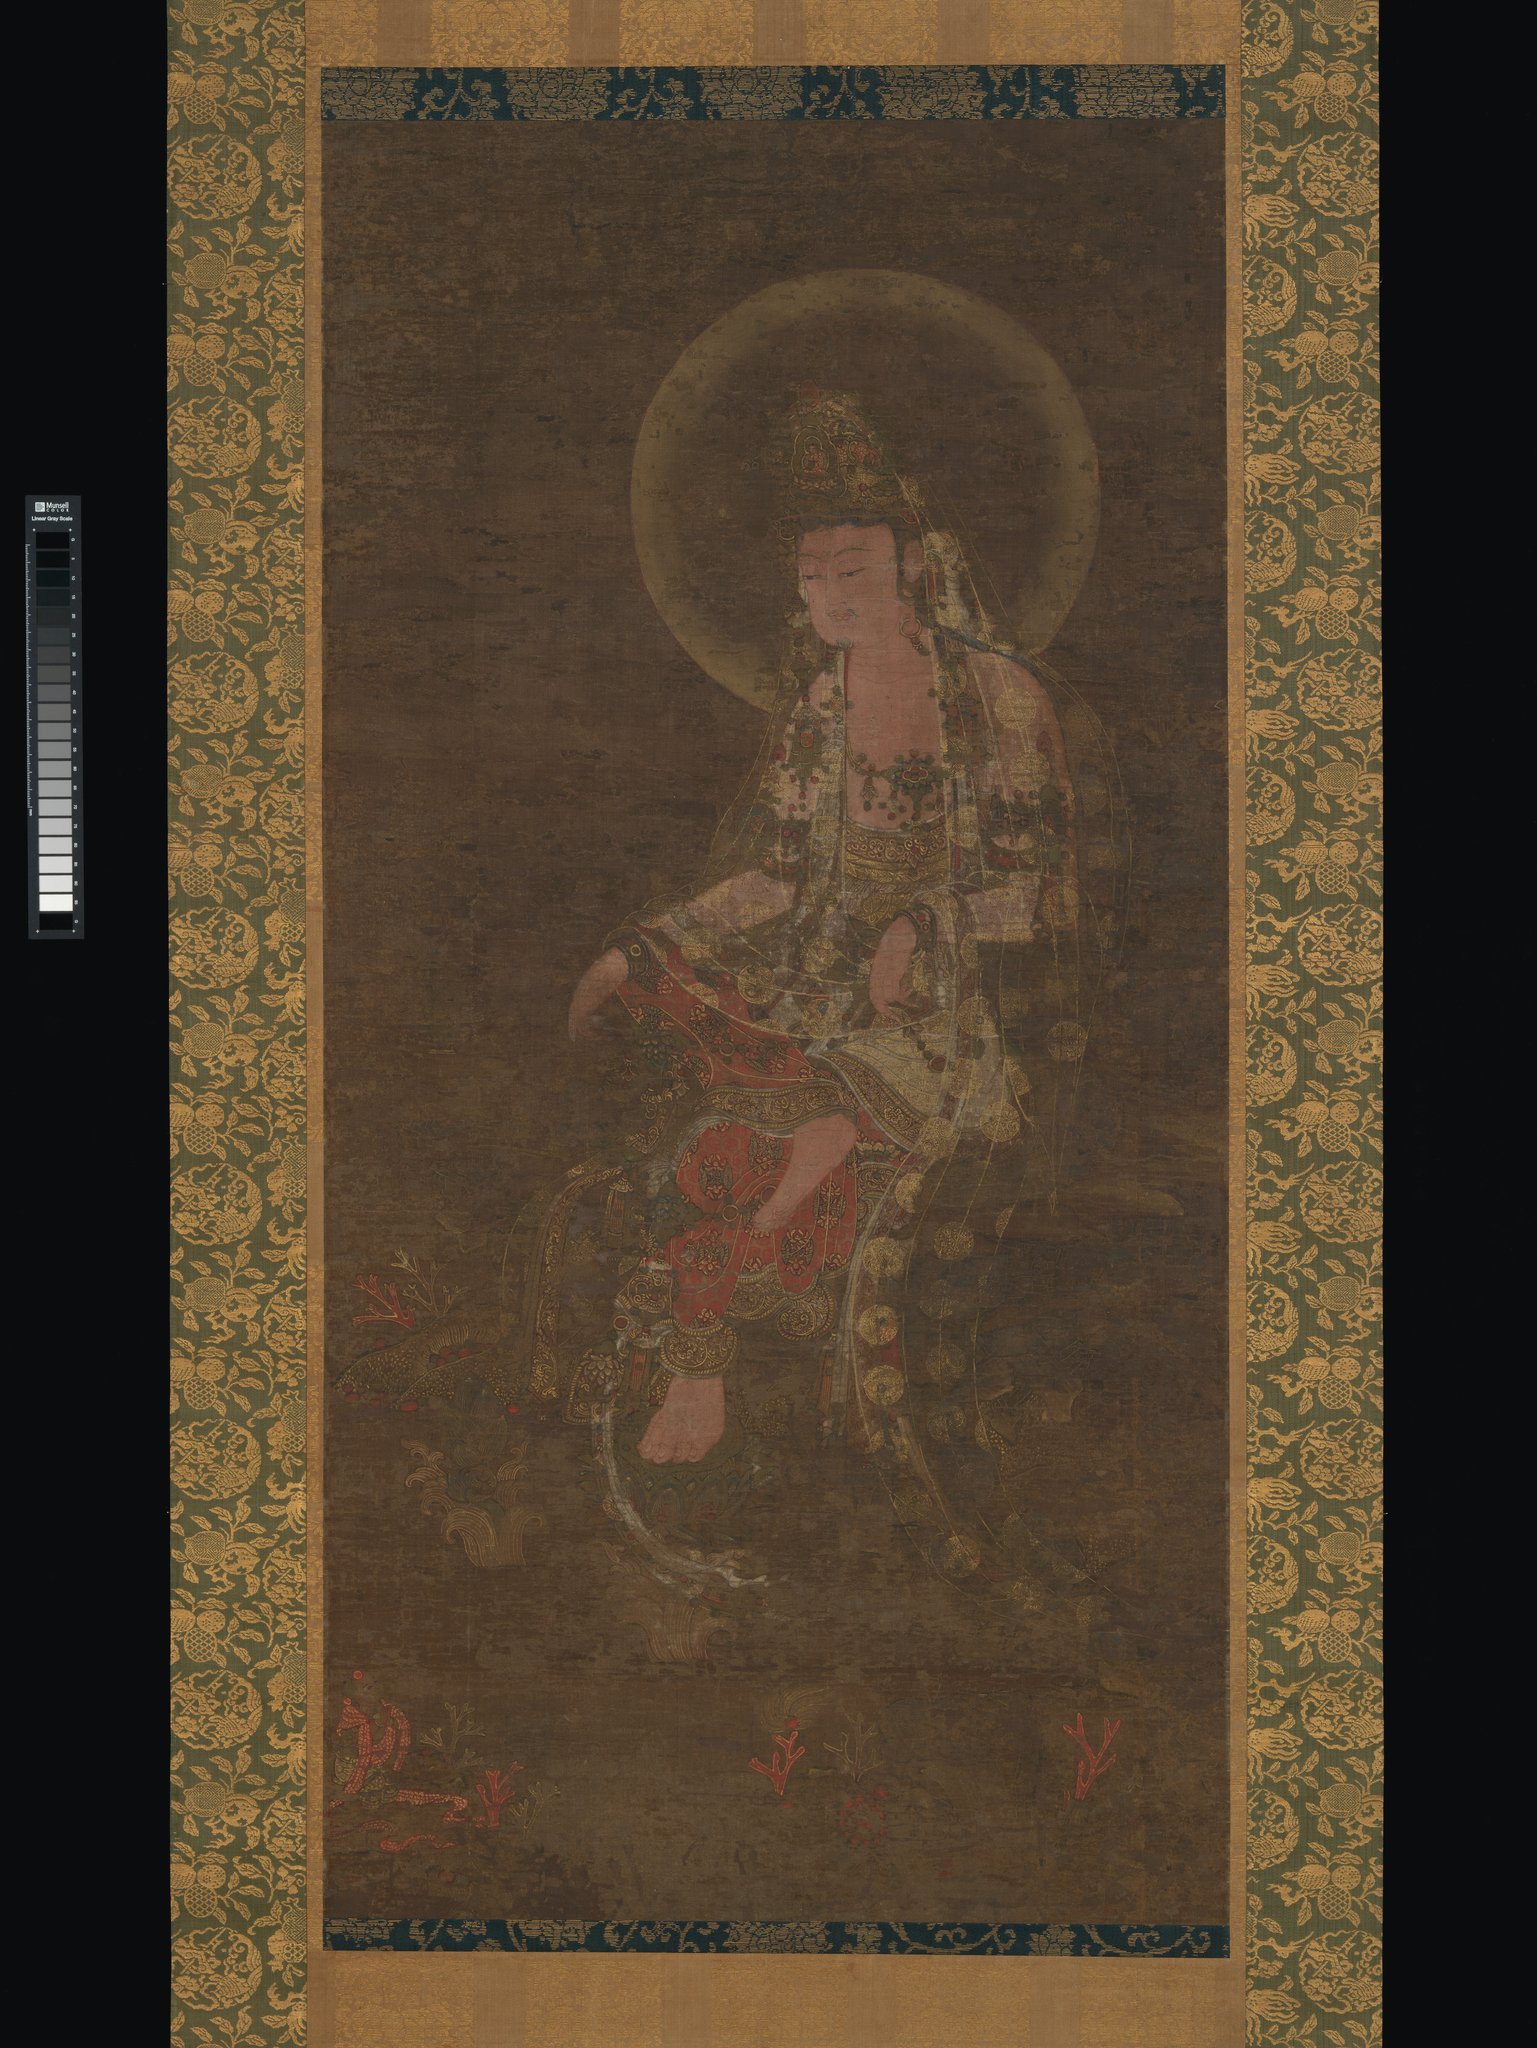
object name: hanging scroll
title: Water-Moon Avalokiteshvara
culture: korean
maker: unidentified artist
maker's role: artist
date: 1301-1400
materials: gold, ink, silk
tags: moon,buddhism,avalokiteshvara,bodhisattvas